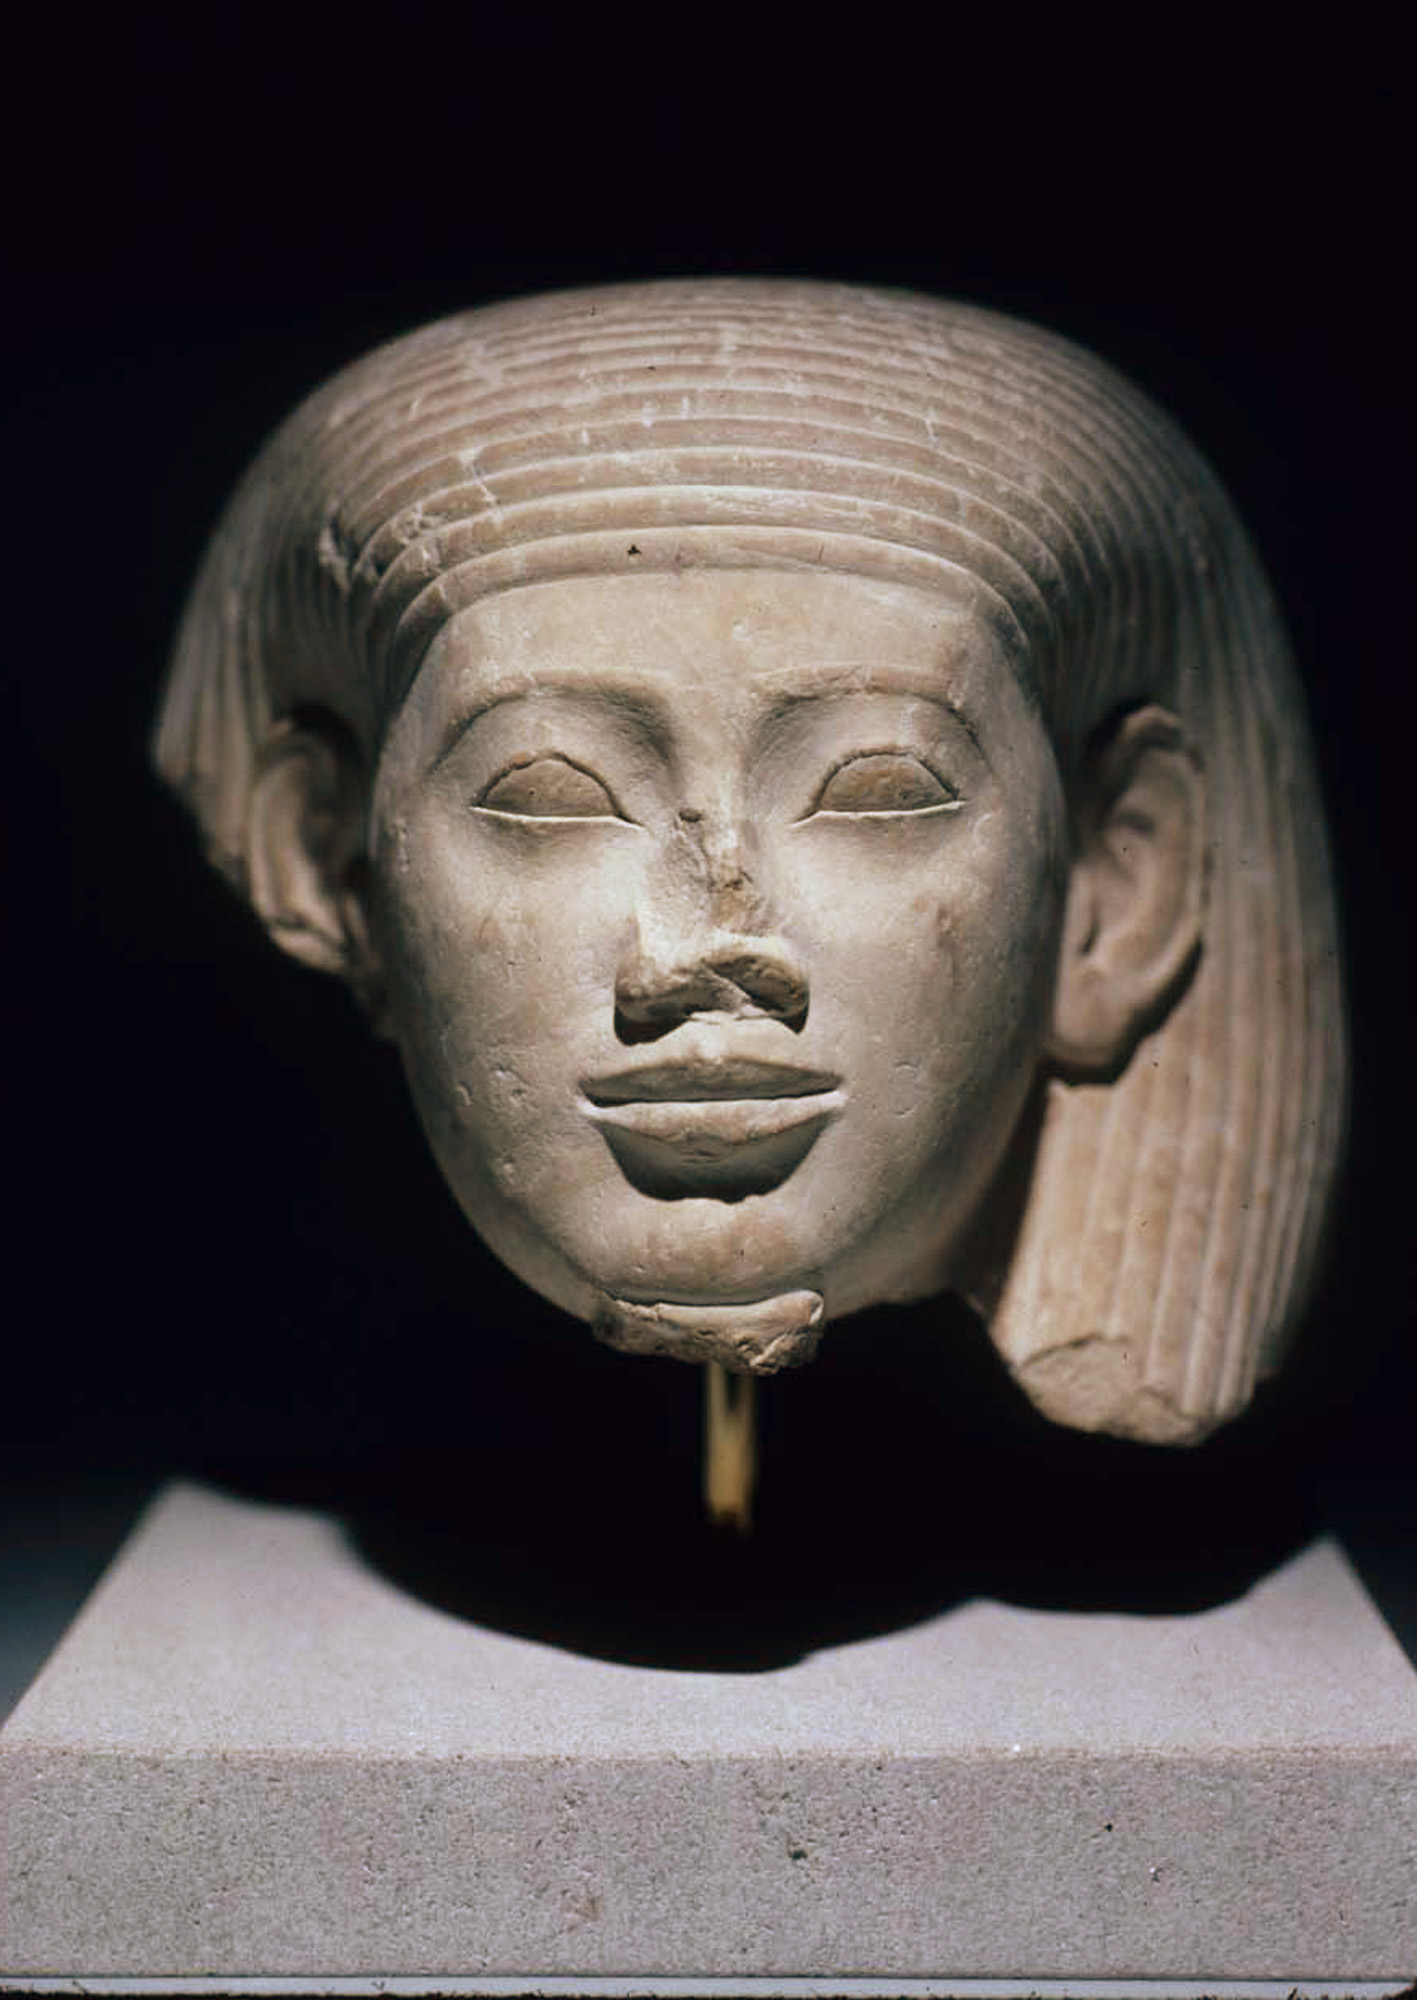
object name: head, god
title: Head of a God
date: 1429-1400 BCE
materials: limestone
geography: upper egypt, thebes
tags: heads